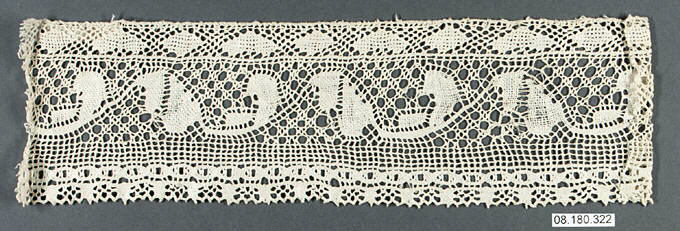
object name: fragment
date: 1801-1900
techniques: lace